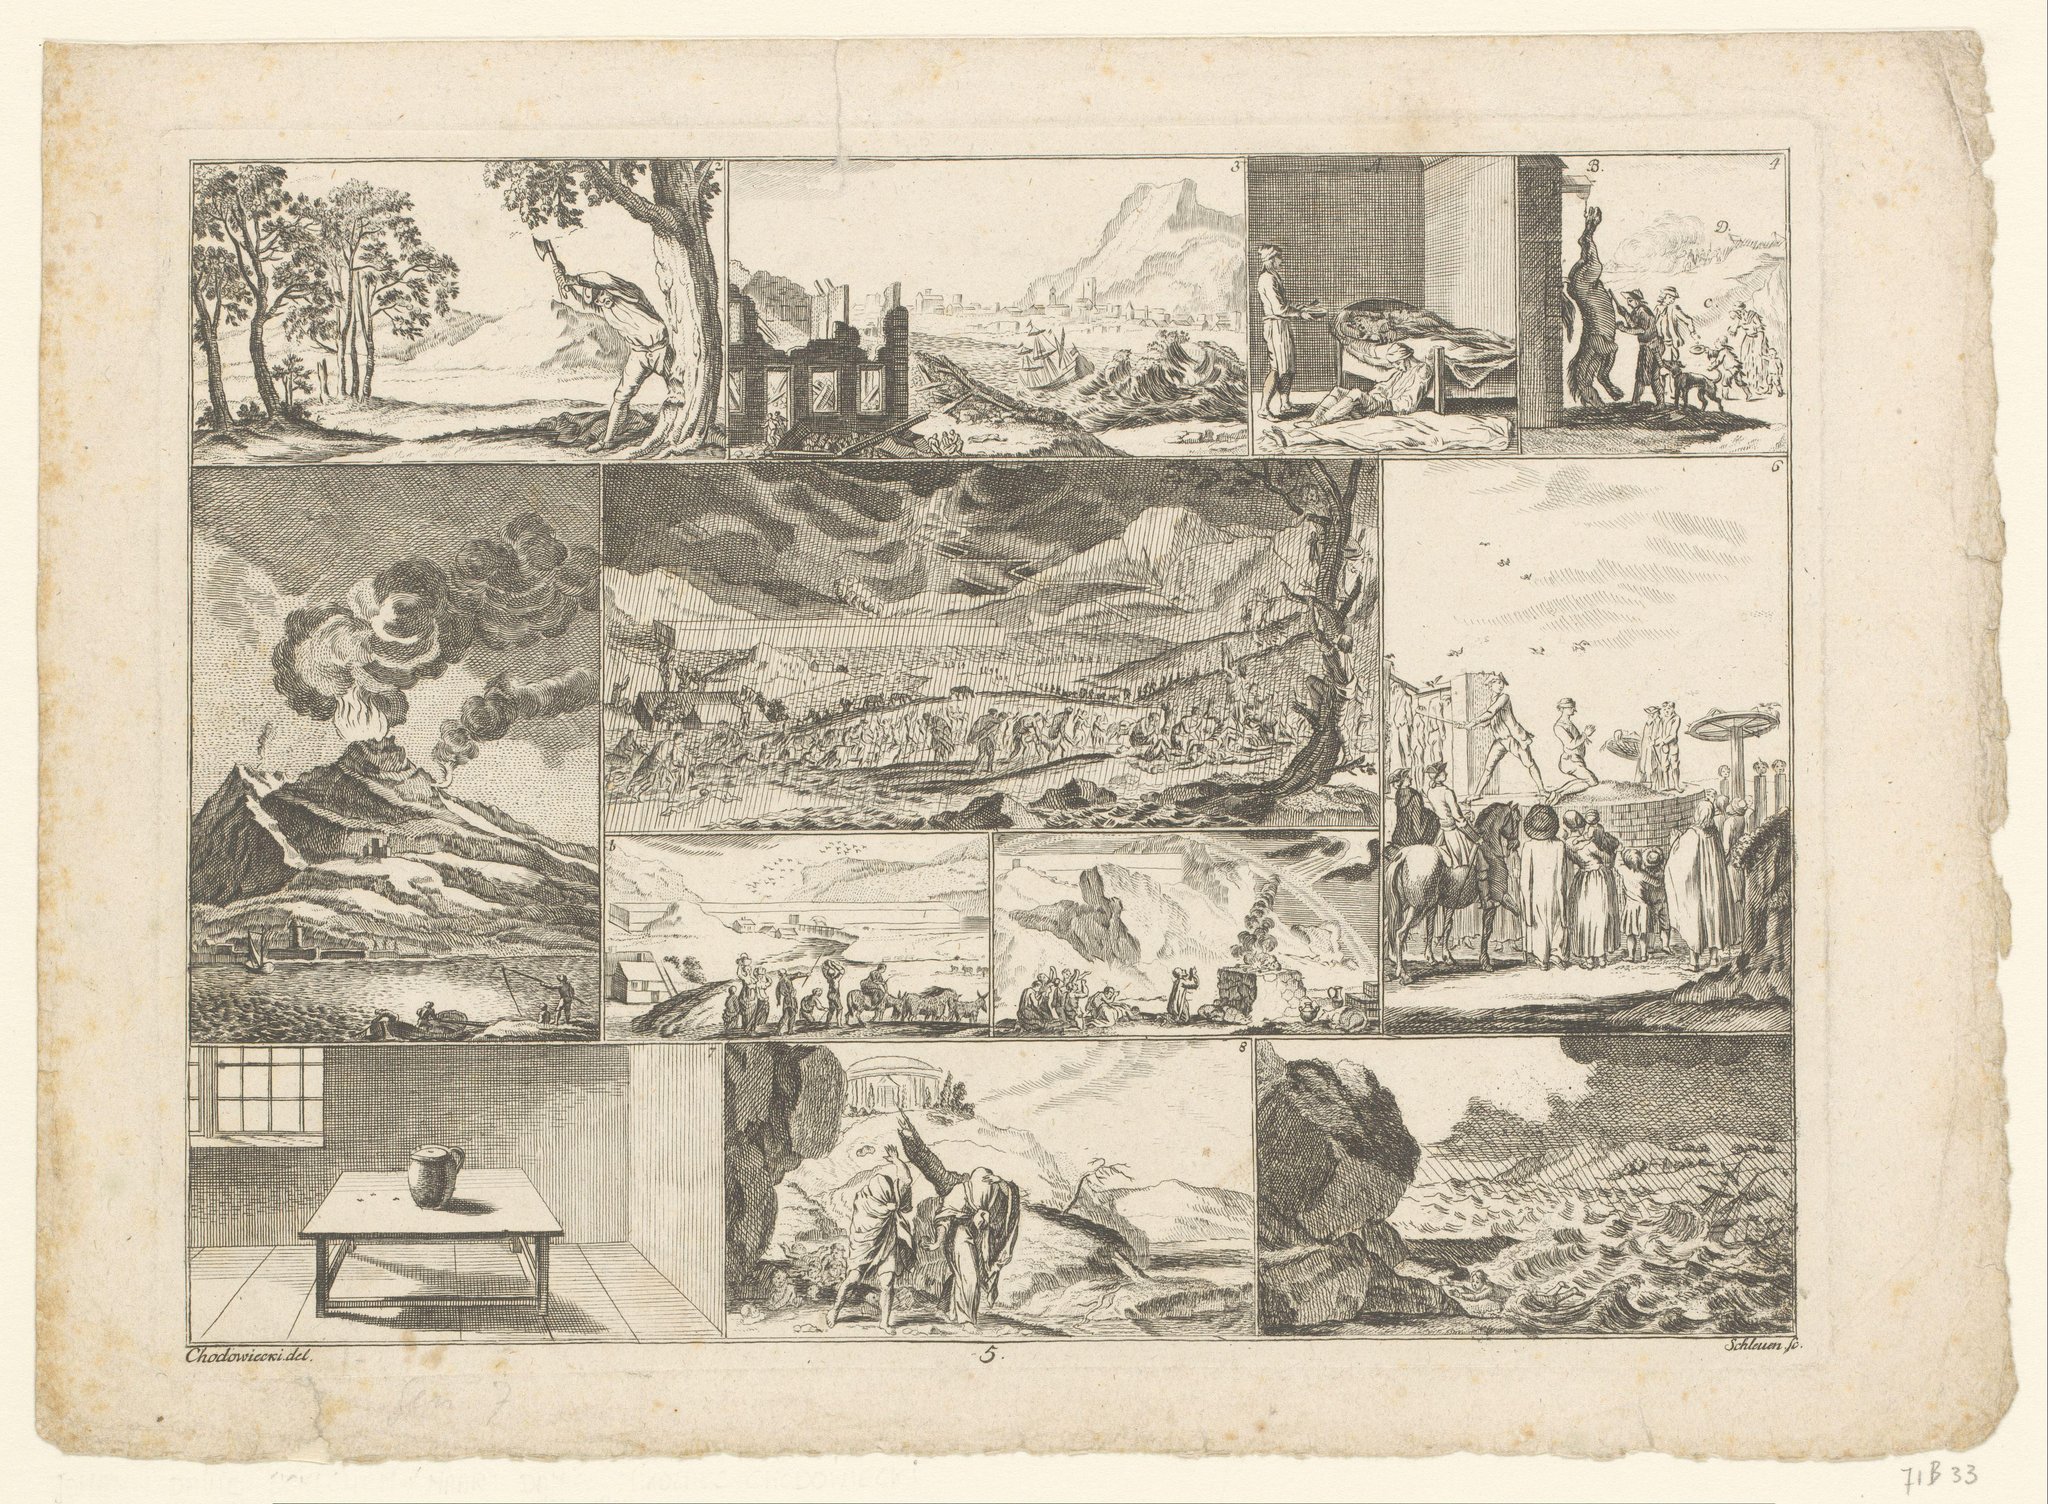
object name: print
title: Zondvloed, omringd door uiteenlopende voorstellingen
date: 1784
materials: paper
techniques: engraving, etching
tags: the flood and destruction of mankind ~ story of noah (genesis 7:10 - 8:17), eruption (of volcano), stones turning into men: stones thrown by deucalion and pyrrha, as directed by the oracle of themis, turn into men (ovid, metamorphoses x 400)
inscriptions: collector's mark: Lugt 2228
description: Maakt deel uit van een serie encyclopedische prenten door verschillende kunstenaars naar ontwerp van Daniel Nikolaus Chodowiecki bij Johann Sigmund Stoy's 'Bilder-Akademie für die Jugend', uitgegeven te Neurenberg in 1784. De prenten waren bedoeld voor kinderen om uit te knippen, op kaarten te plakken en vervolgens op logische wijze te rangschikken (zie Heesen, Anke te. The World in a Box: The Story of an Eighteenth-Century Picture Encyclopedia. Chicago: University of Chicago Press, 2002).